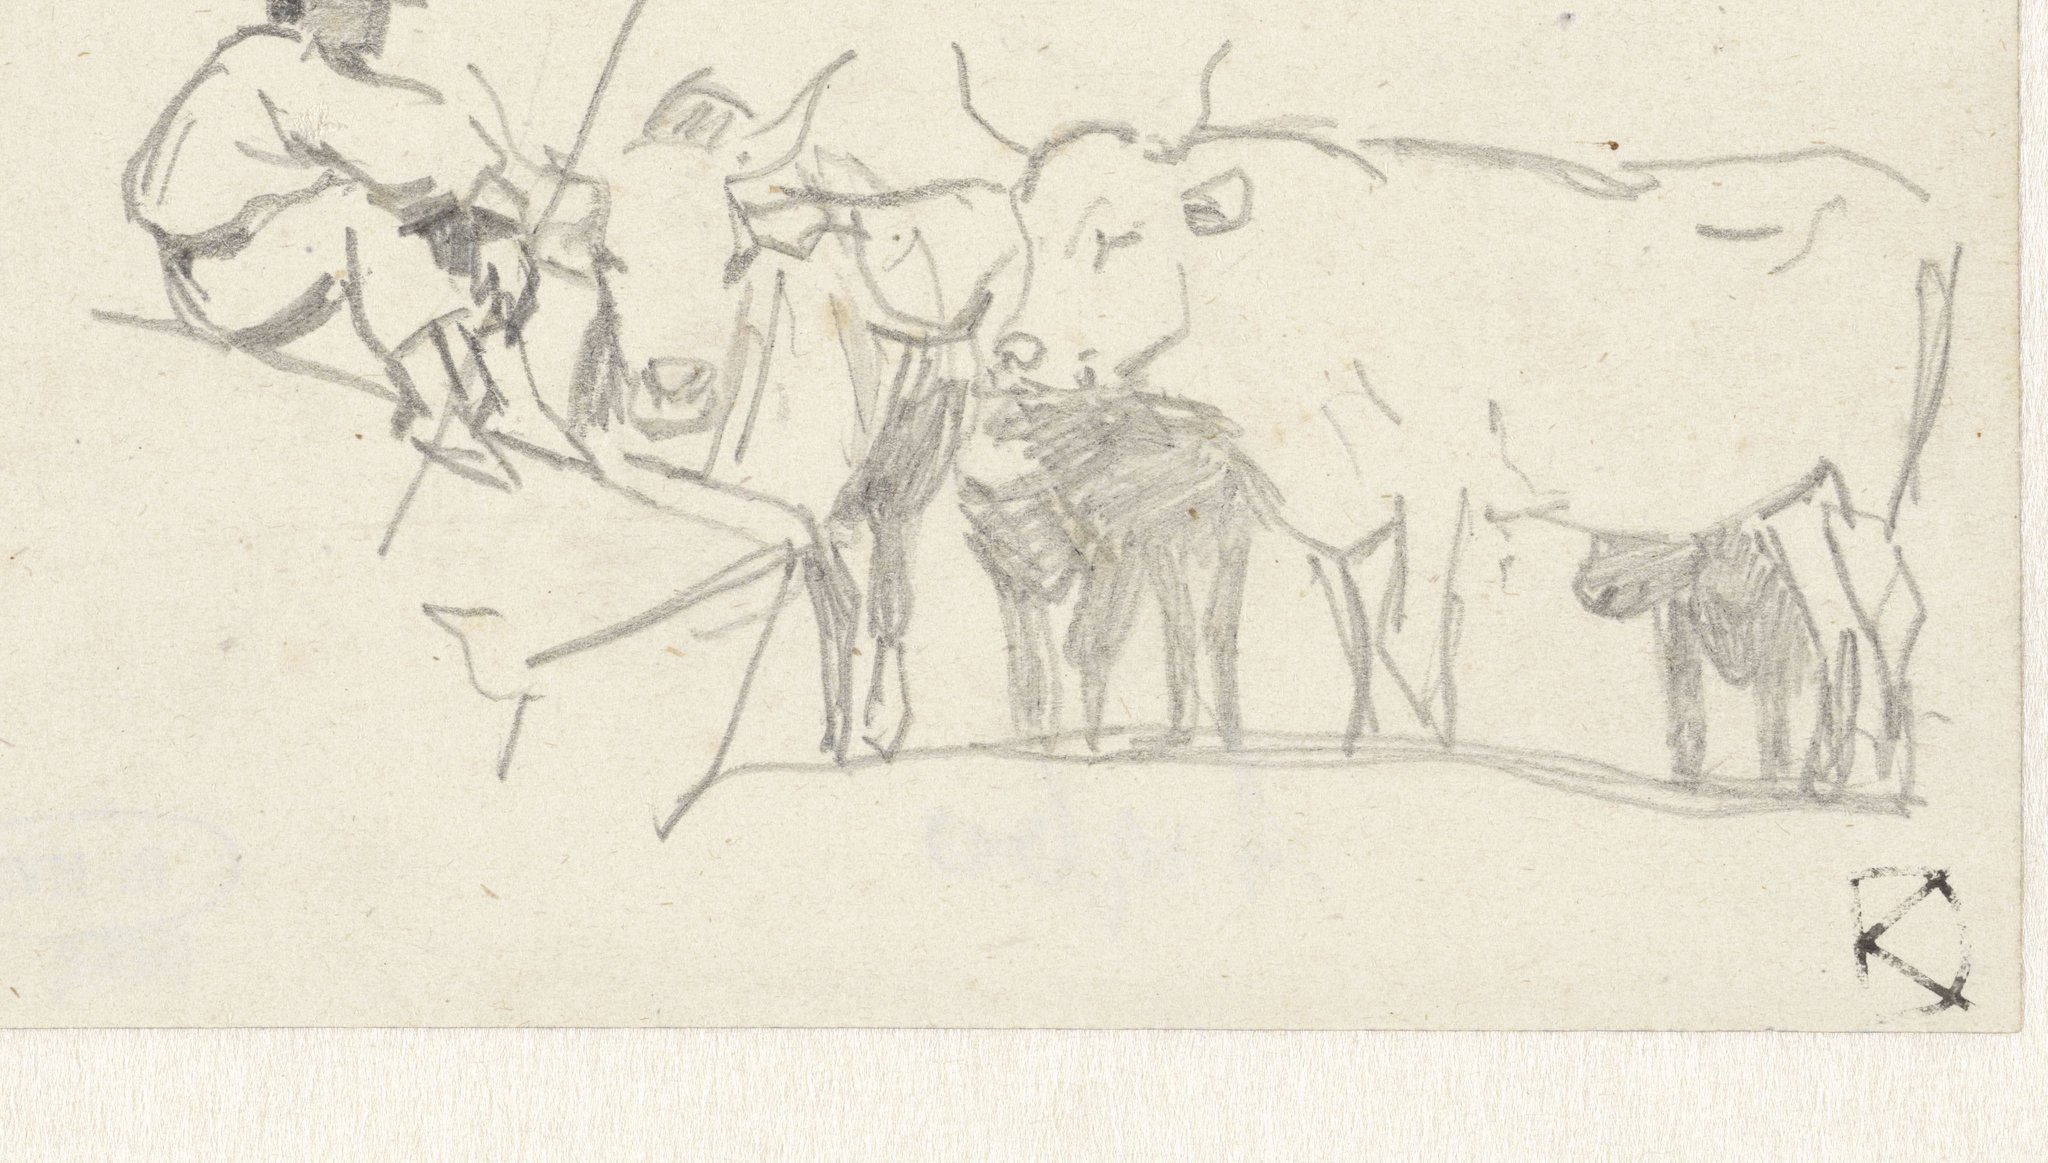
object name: drawing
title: Herder zittend op een rots nabij enkele ossen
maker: johan daniël koelman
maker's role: draughtsman, print maker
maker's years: 1831-1857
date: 1841-1857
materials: paper, pencil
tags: bull, herd, flock